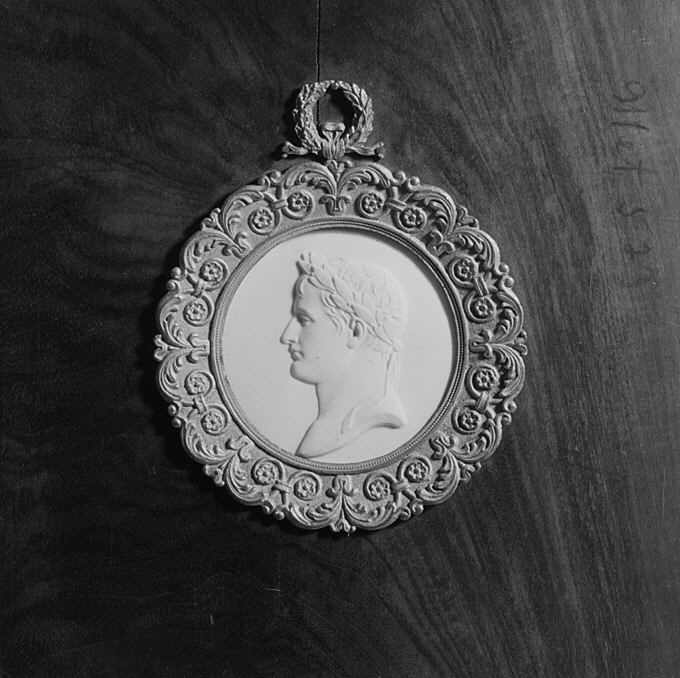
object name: medallion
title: Napoleon I (1769–1821), Emperor of the French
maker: sèvres manufactory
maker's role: manufactory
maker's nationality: french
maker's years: 1740-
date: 1867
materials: biscuit, porcelain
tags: napoleon i,profiles